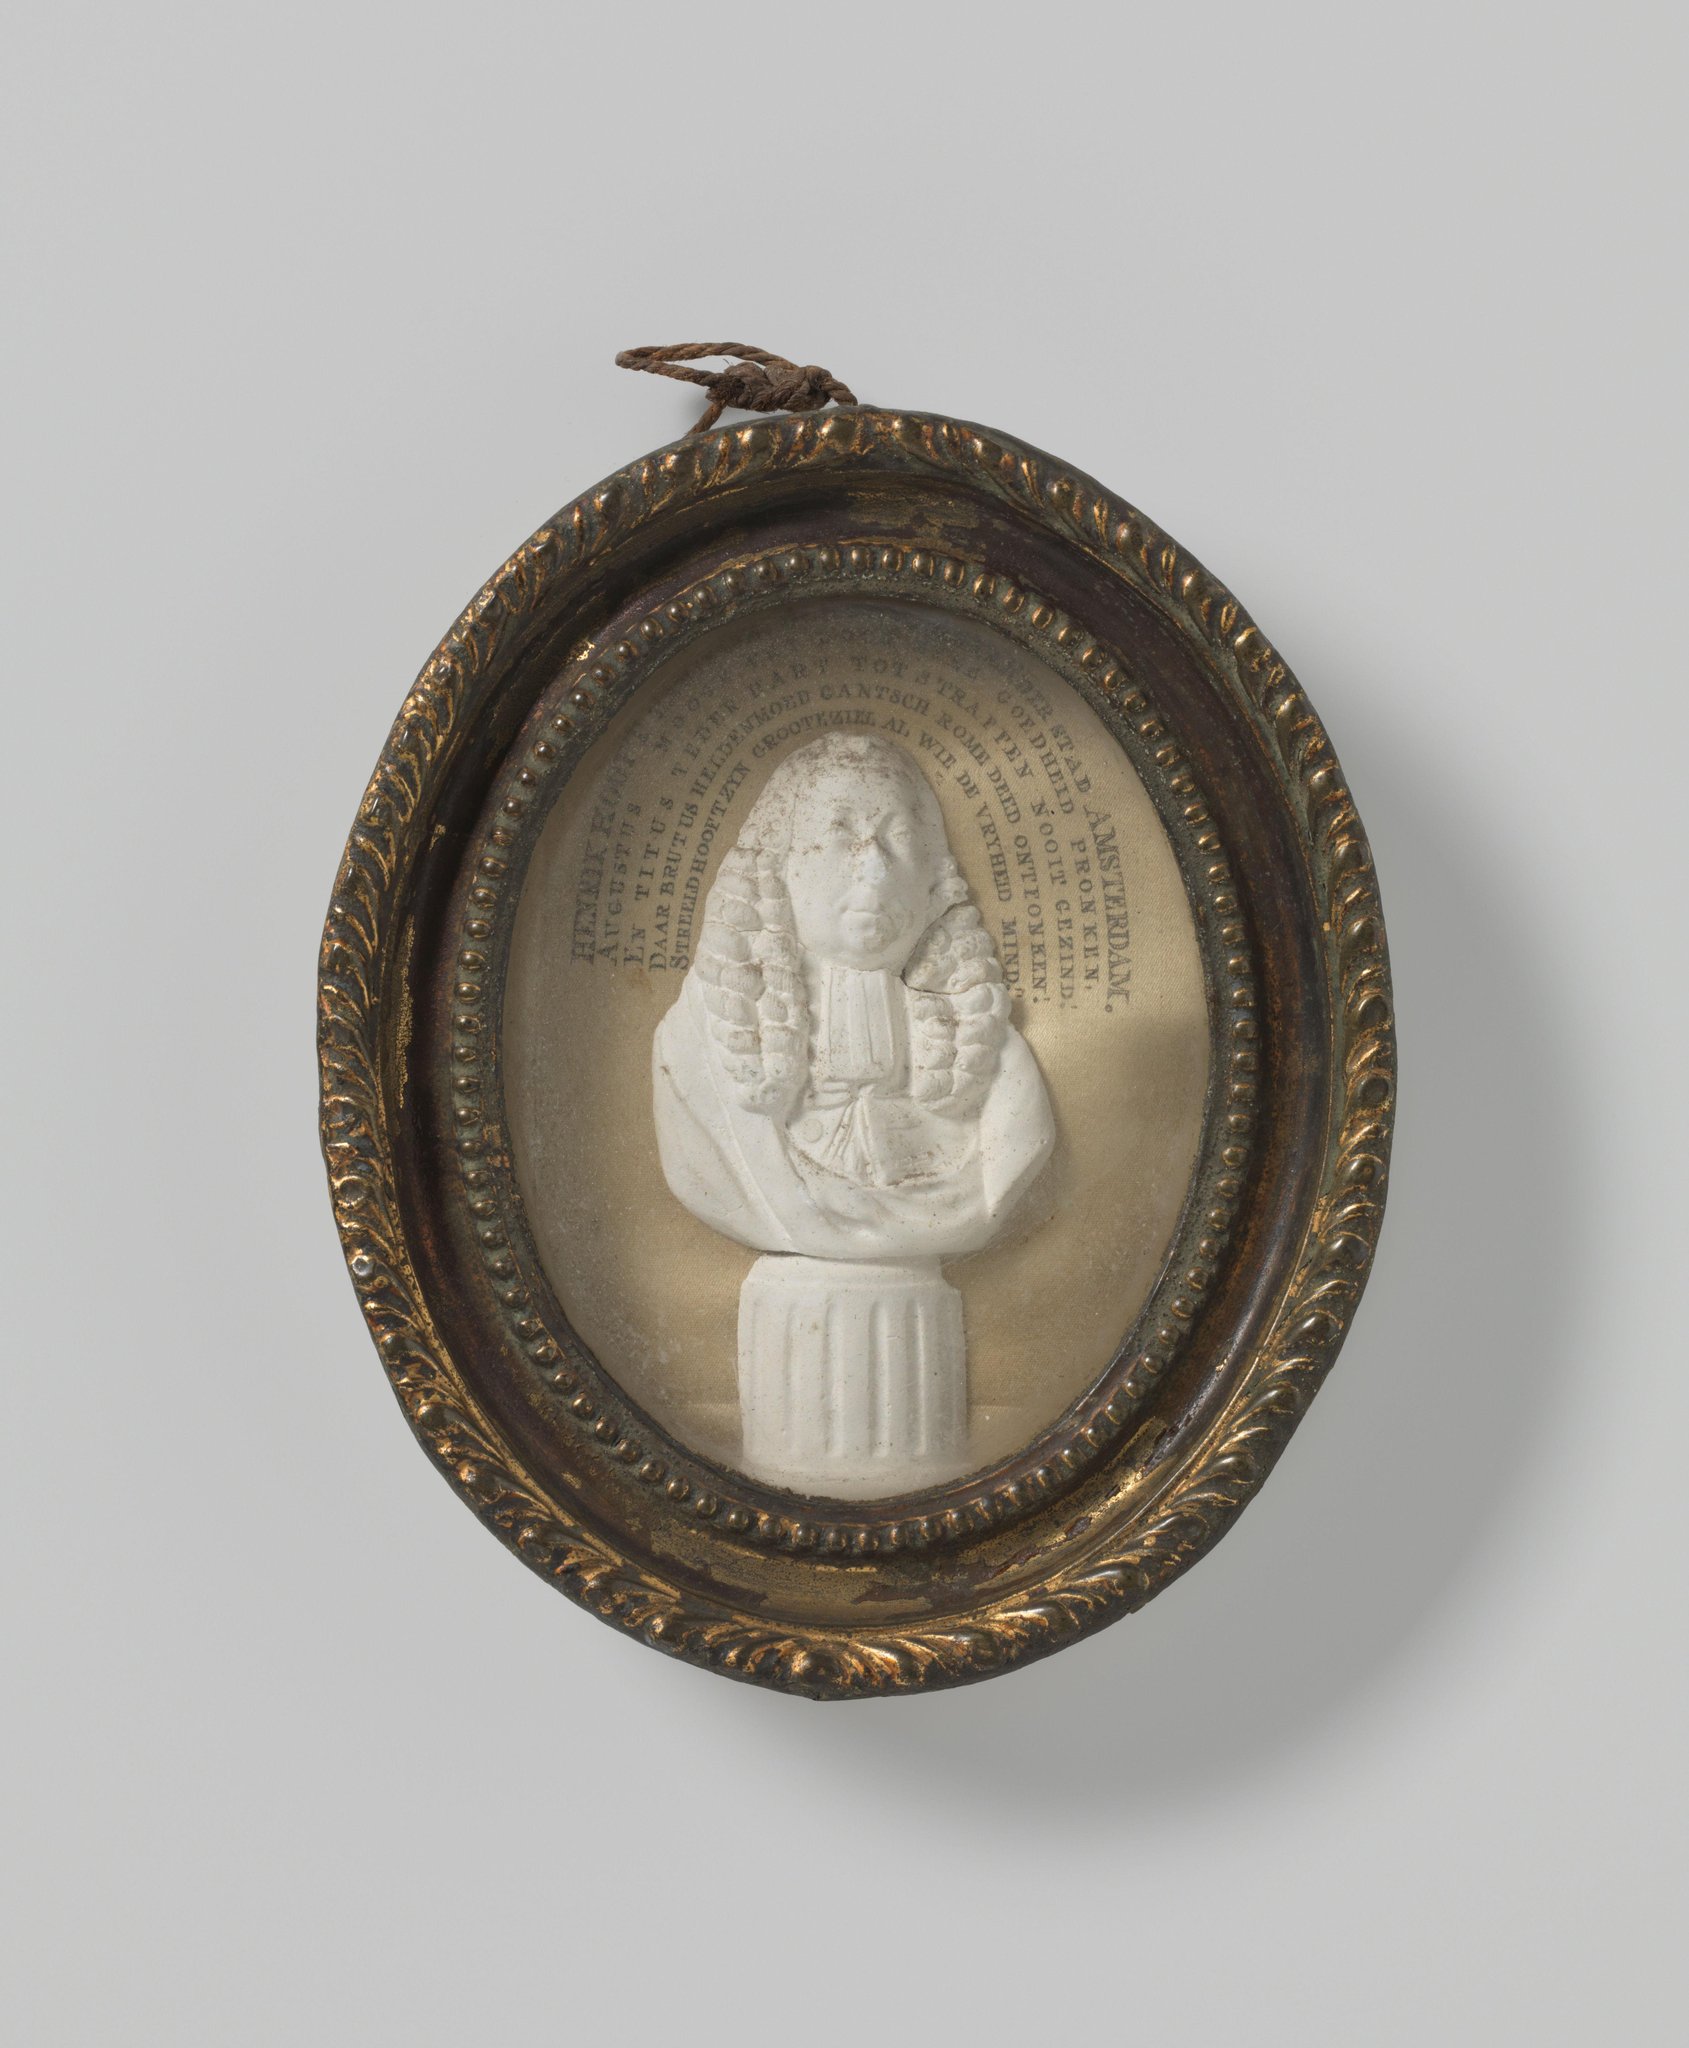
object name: relief sculpture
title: Reliefje in lijstje. Portret Hendrick Hooft.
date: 1787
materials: papier mâché